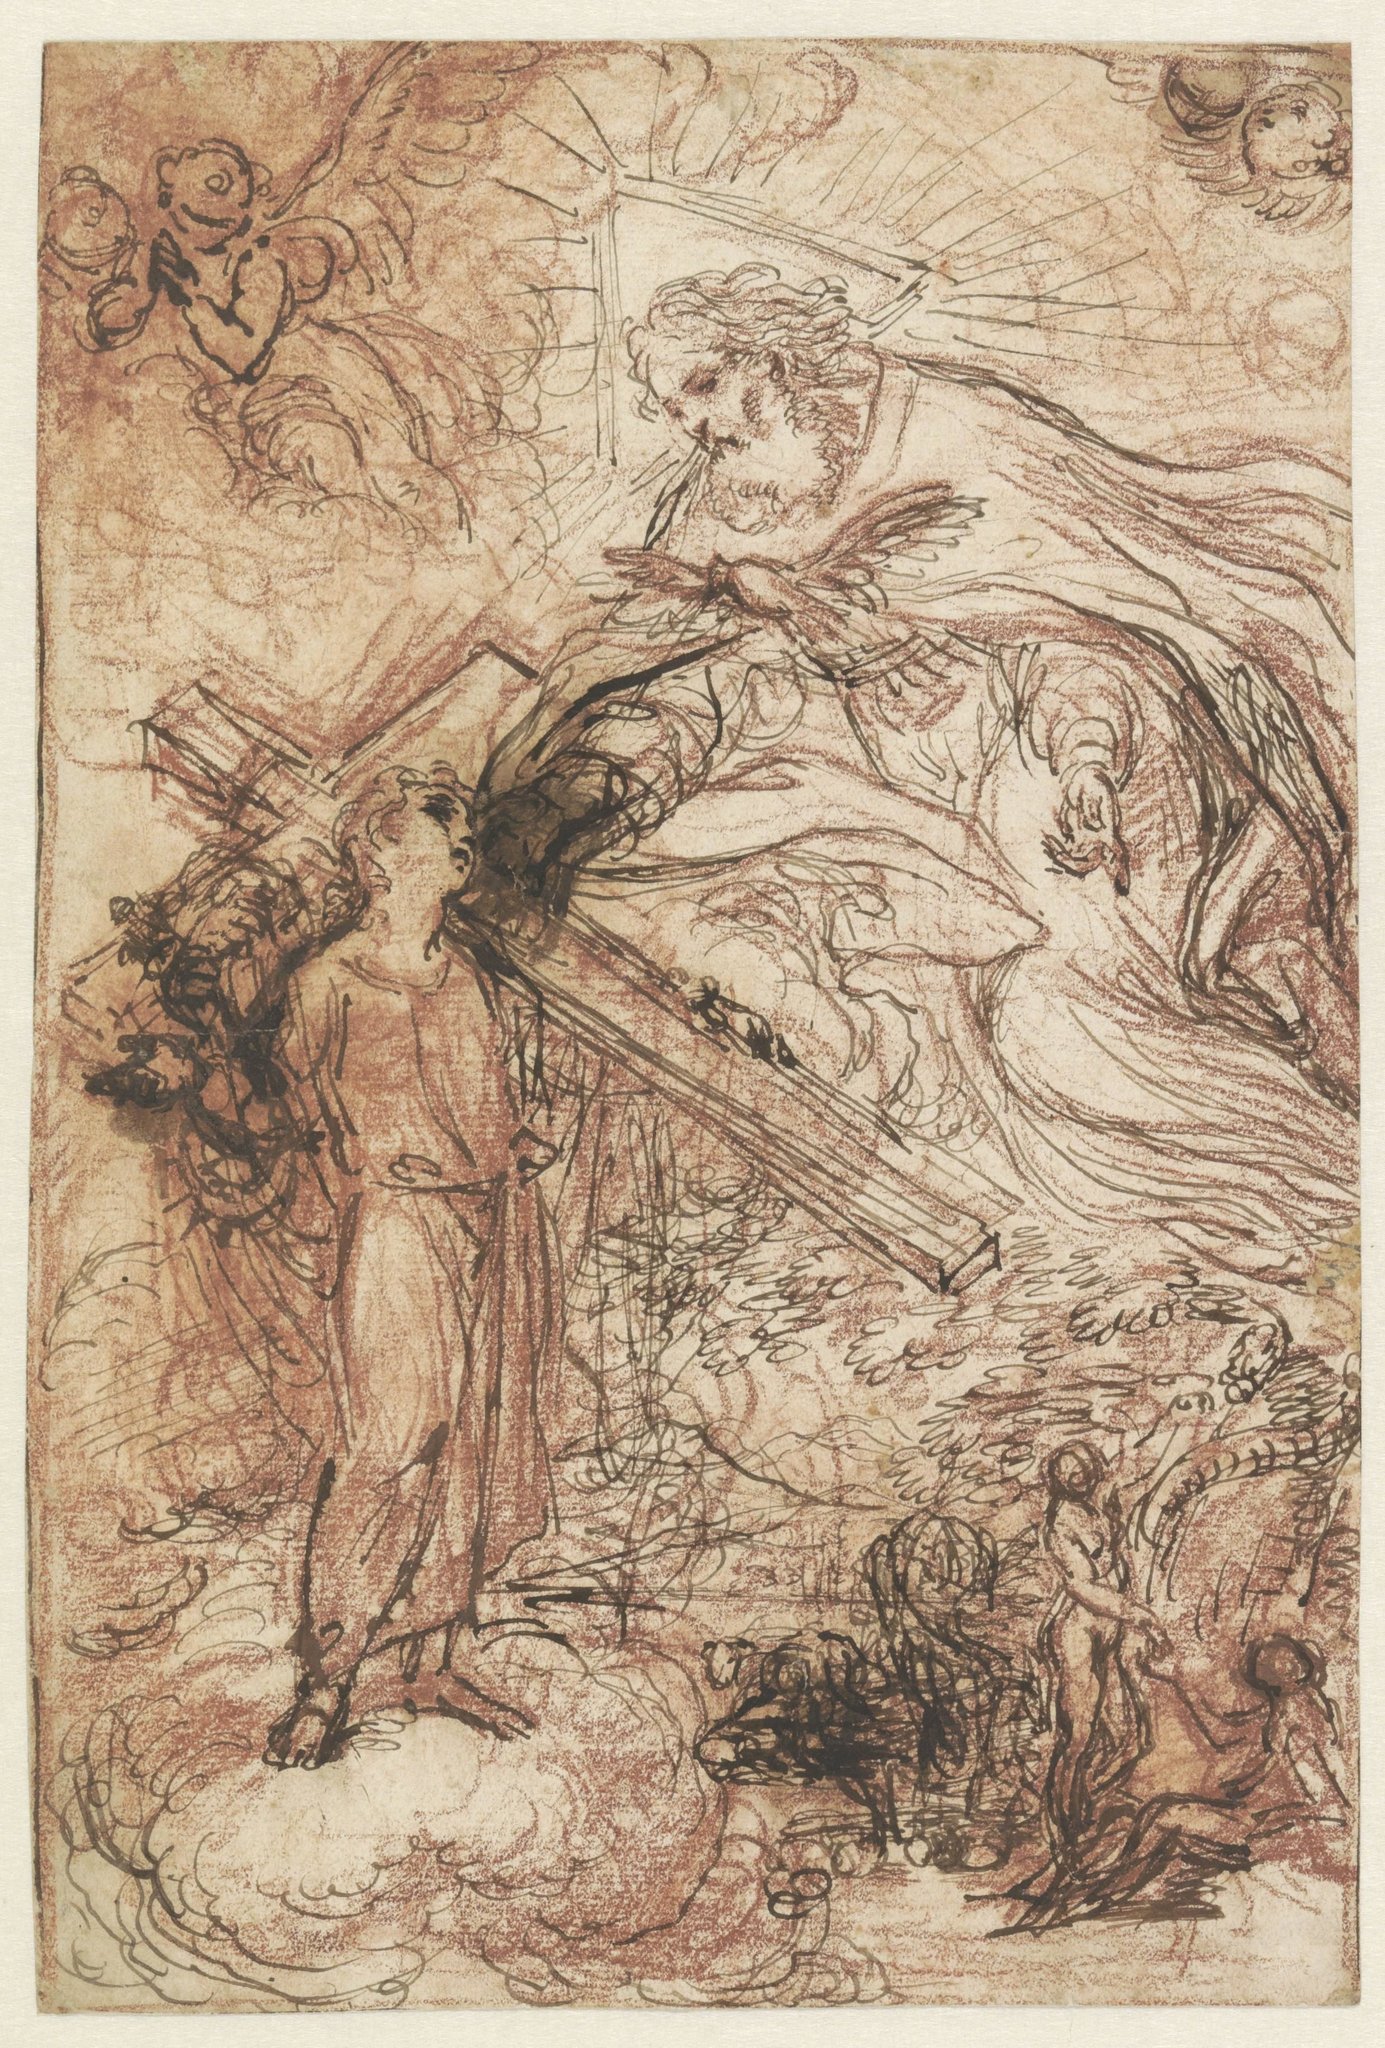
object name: drawing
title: De Heilige Drieëenheid en de zondeval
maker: agostino masucci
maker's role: draughtsman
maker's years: 1691-1758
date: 1701-1758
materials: chalk, ink, paper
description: De Heilige Drieëenheid (met een jeugdige kruisdragende Christus) en de zondeval.